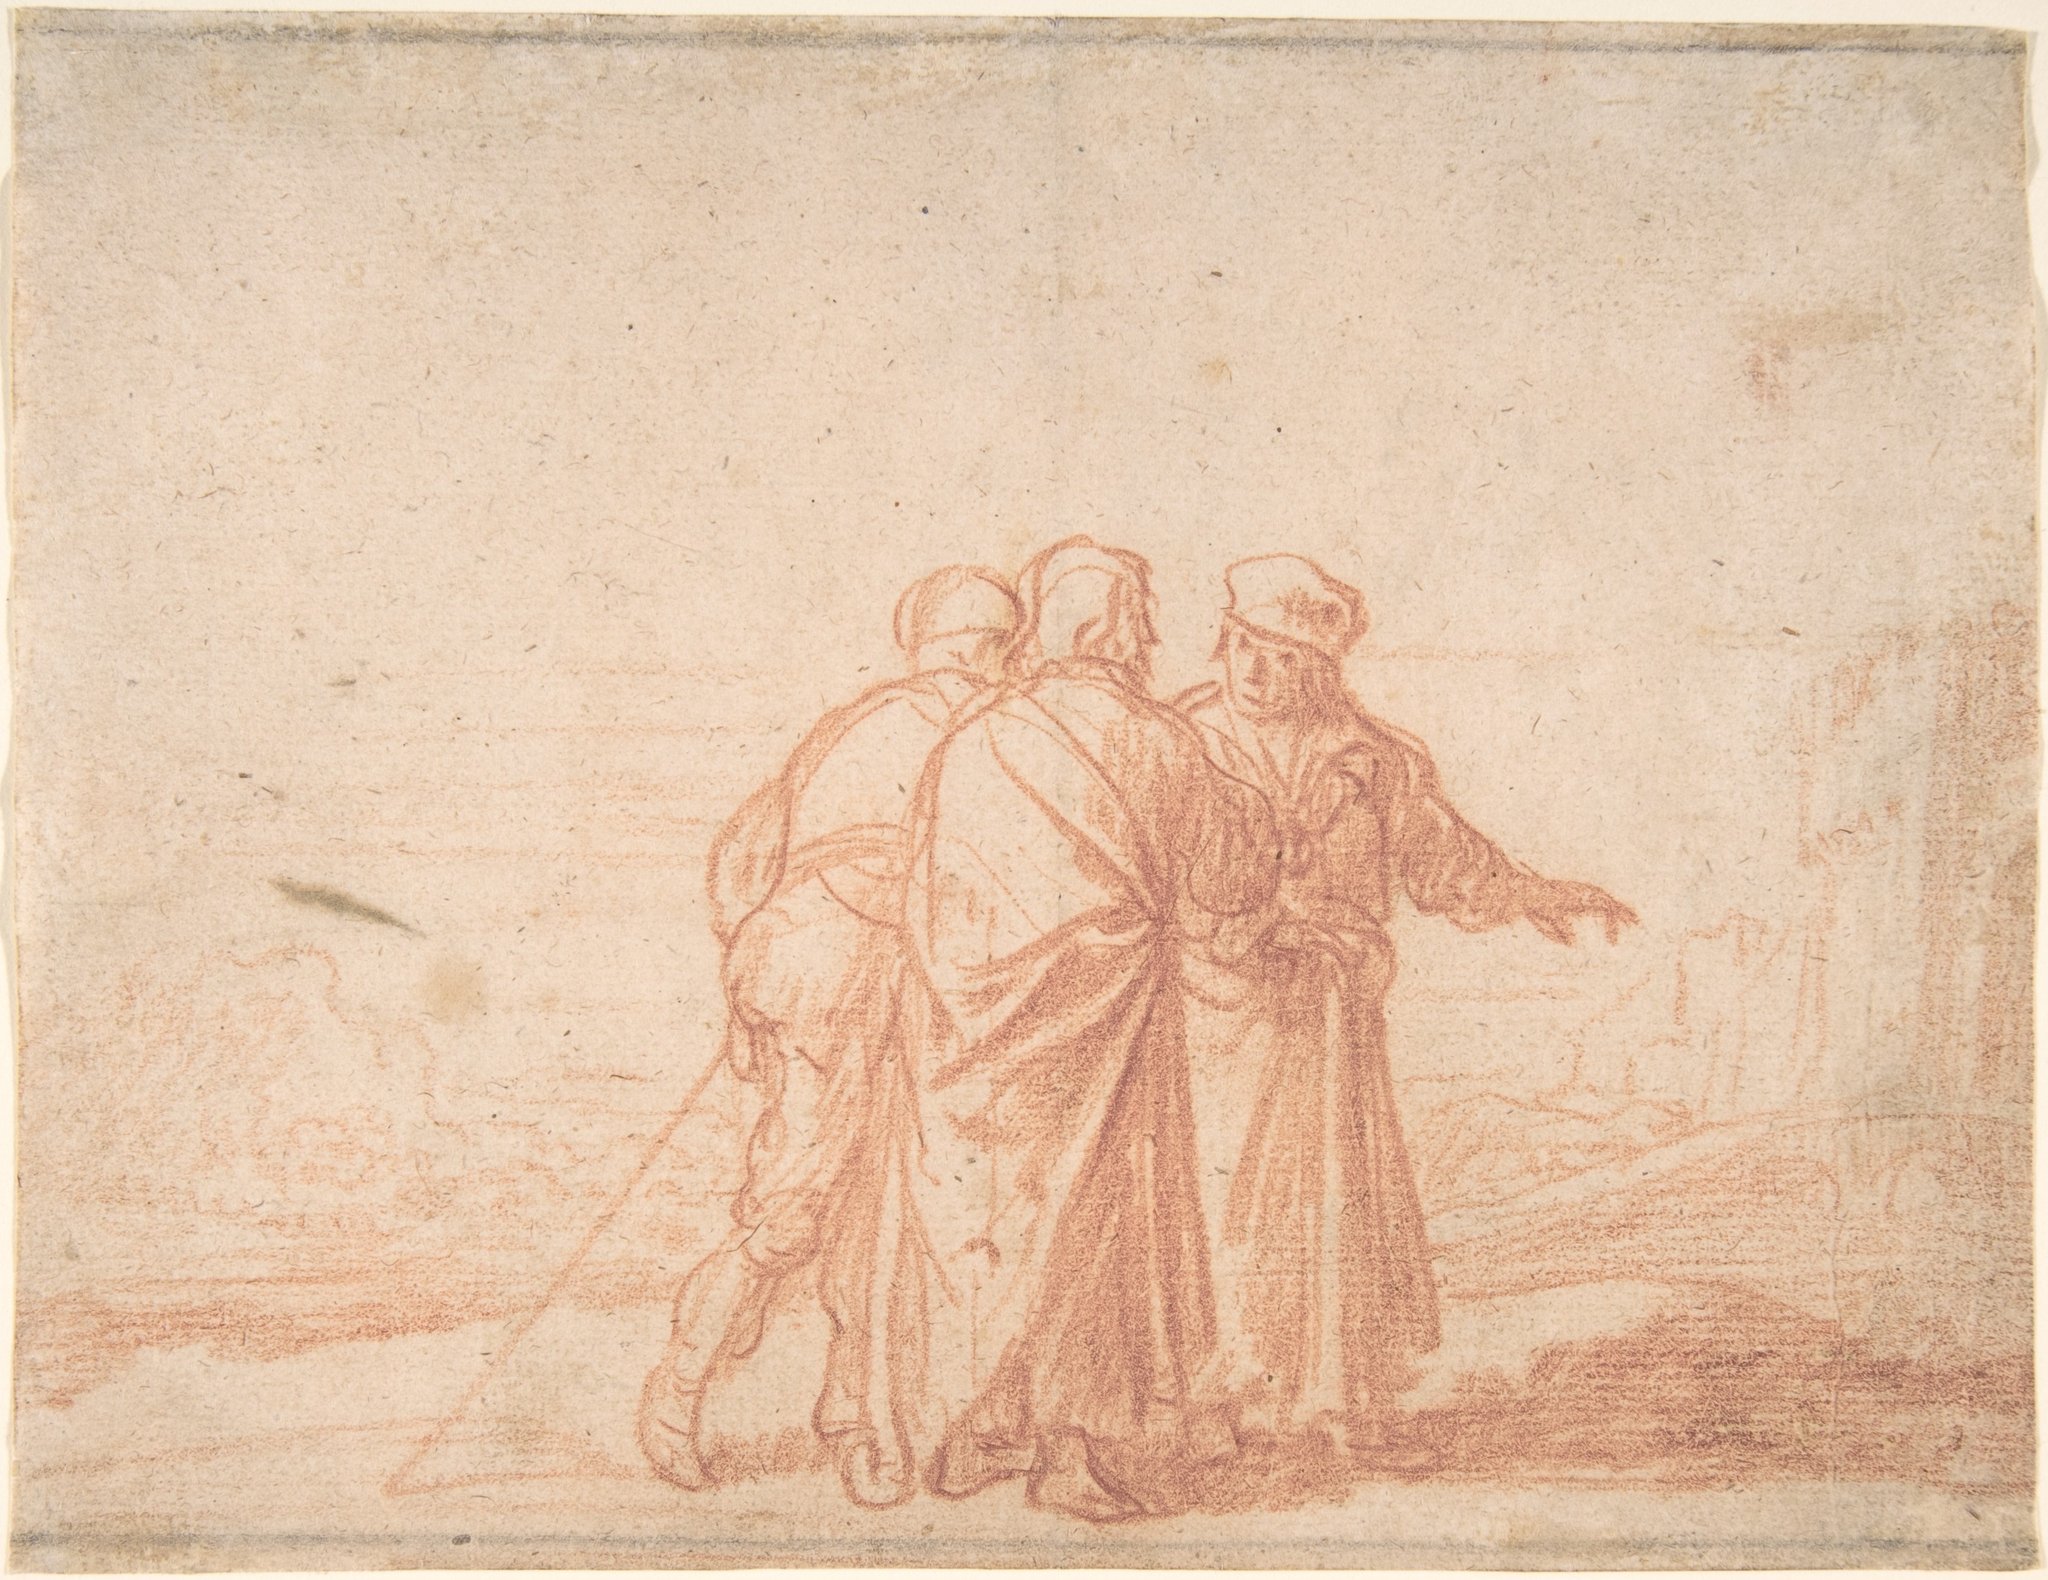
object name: drawing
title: The Road to Emmaus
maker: claes moeyaert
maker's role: artist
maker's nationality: dutch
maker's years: 1591-1655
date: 1601-1700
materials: chalk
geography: netherlands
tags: men,jesus